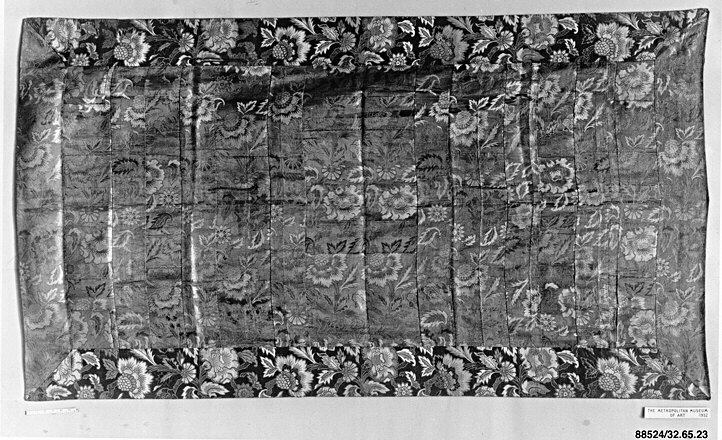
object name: robe, priest's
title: Priest's Robe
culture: japanese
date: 1801-1900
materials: silk